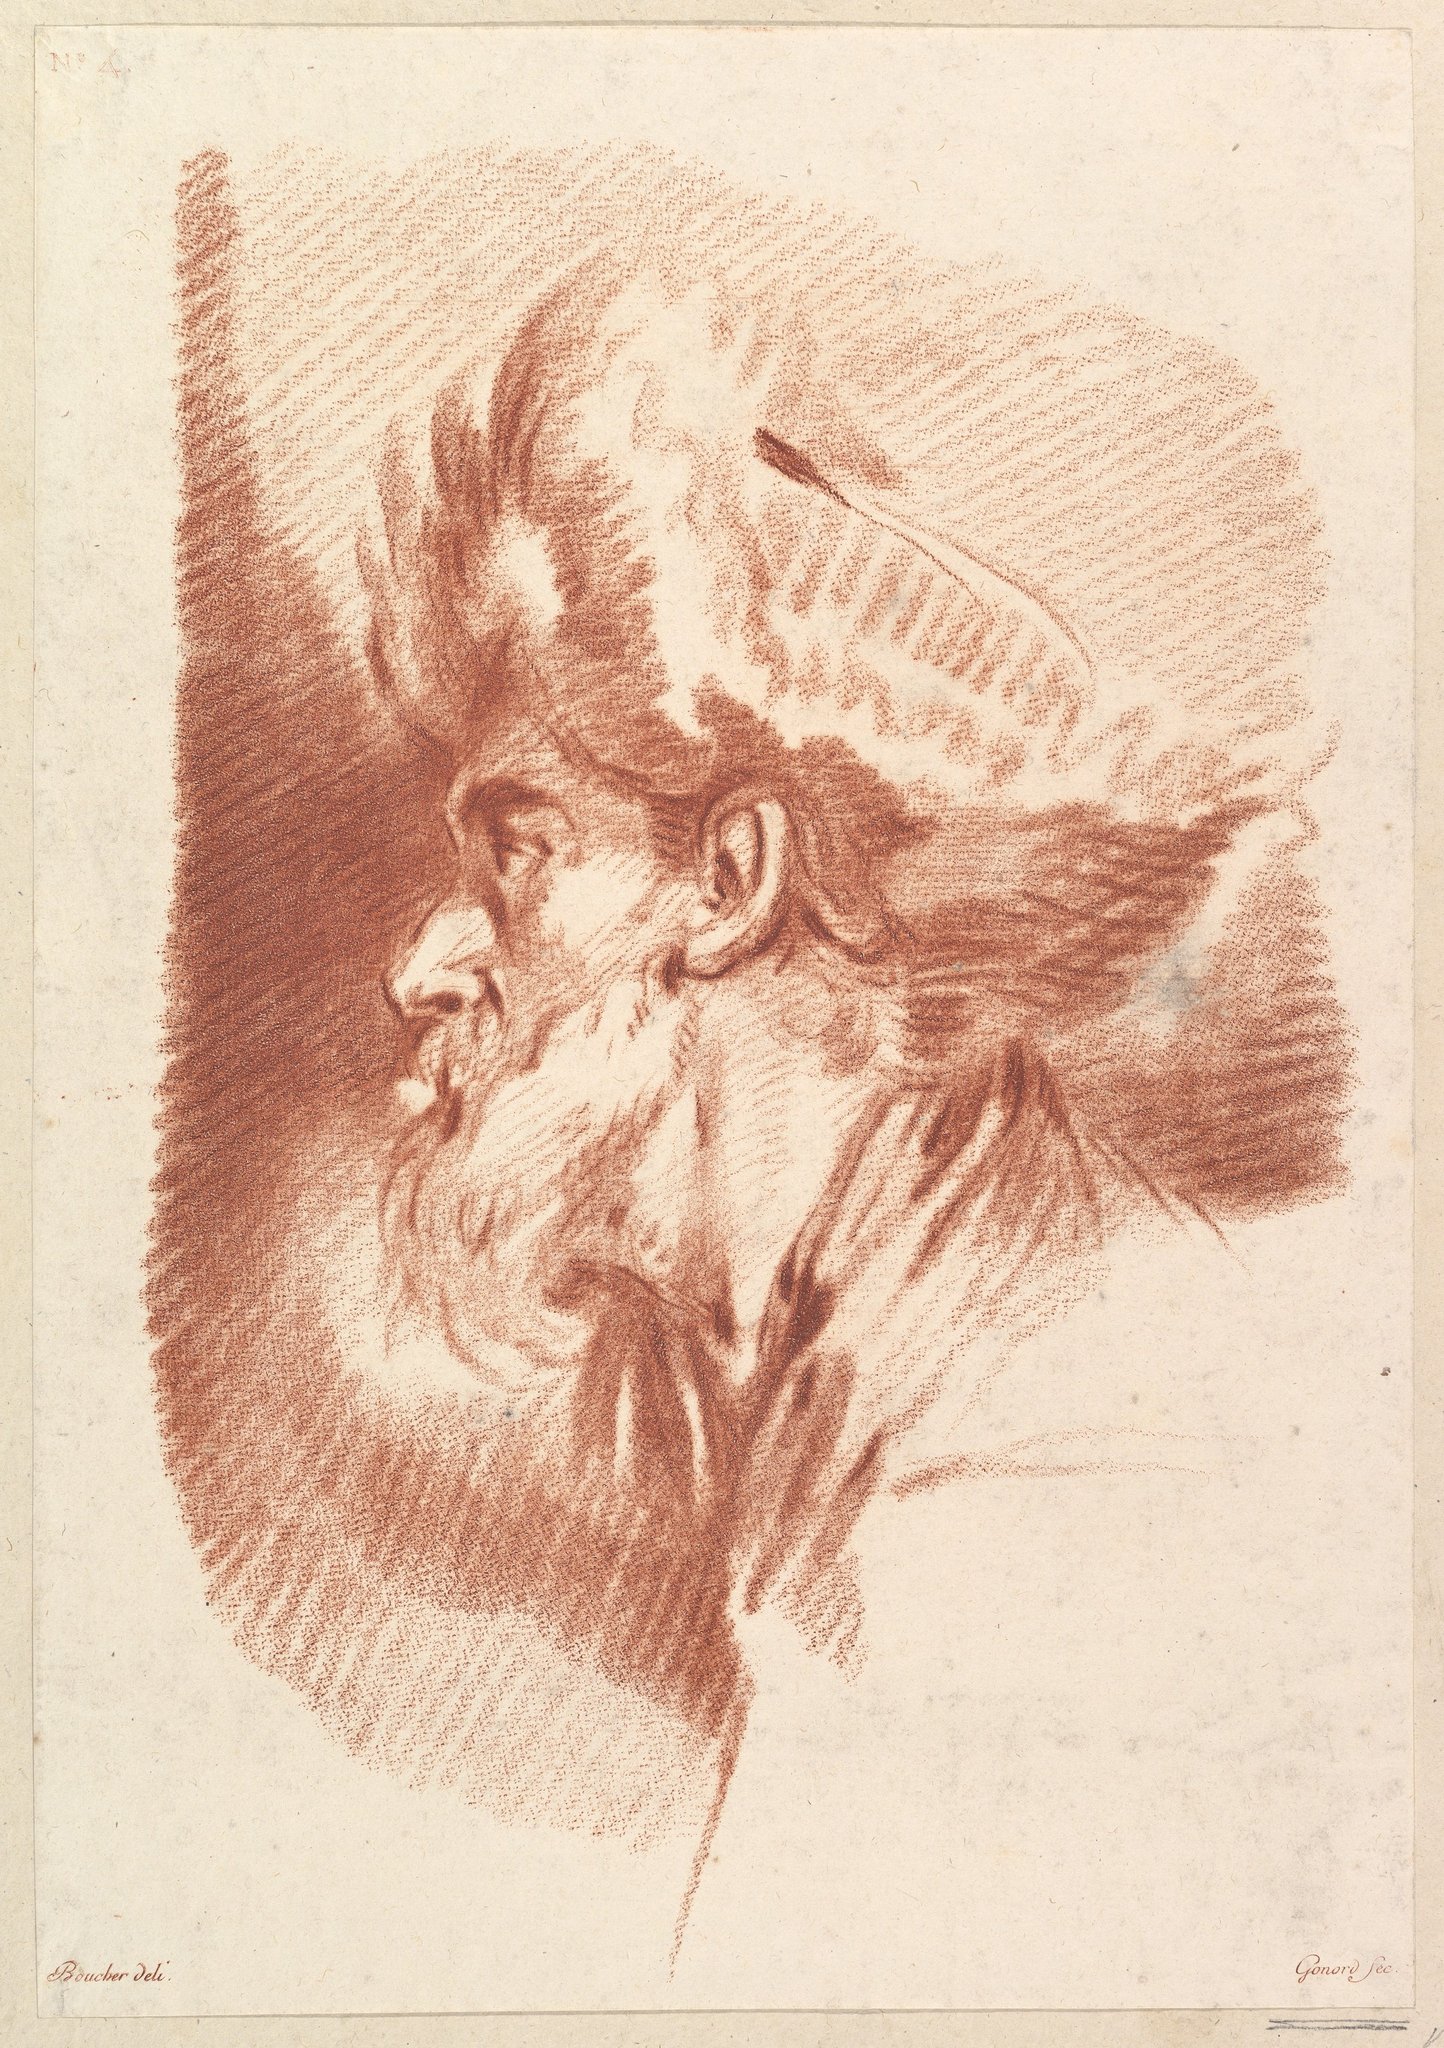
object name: print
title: Untitled (Head Of A Man In Turban)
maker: françois gonord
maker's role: artist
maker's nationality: french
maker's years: 1756-1825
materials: ink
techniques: printmaking, engraving, printing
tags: men